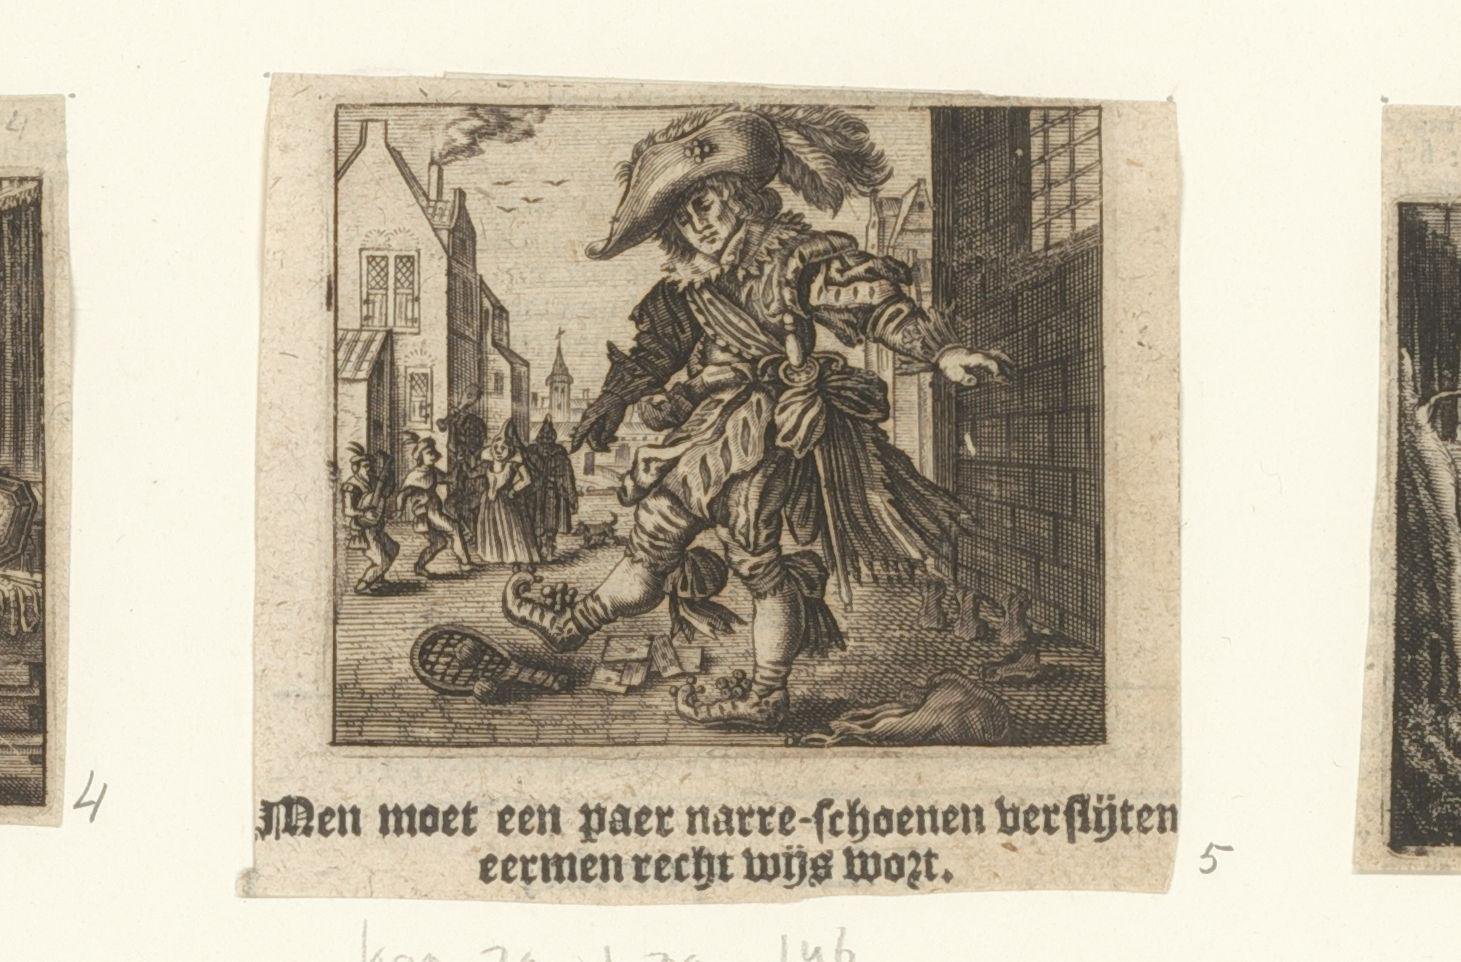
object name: print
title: Men moet een paer narre-schoenen verslijten eermen recht wijs wort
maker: Anonymous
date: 1635-1715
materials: paper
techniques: engraving, letterpress printing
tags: court jester, court fool, proverbs, sayings, etc., shoes, sandals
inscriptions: collector's mark: Lugt 1641, stamp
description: Veel versies van dit embleem verschenen in verschillende uitgave van Spiegel van den Ouden ende Nieuwen Tydt. Zoals: Cats, Jacob. Spiegel van den Ouden ende Nieuwen-tijt, Bestaende uyt Spreeck-woorden (...). Dordrecht: Jacob Braat, 1647. Maar ook in andere publicaties (1665, 1671, 1715, 1722).